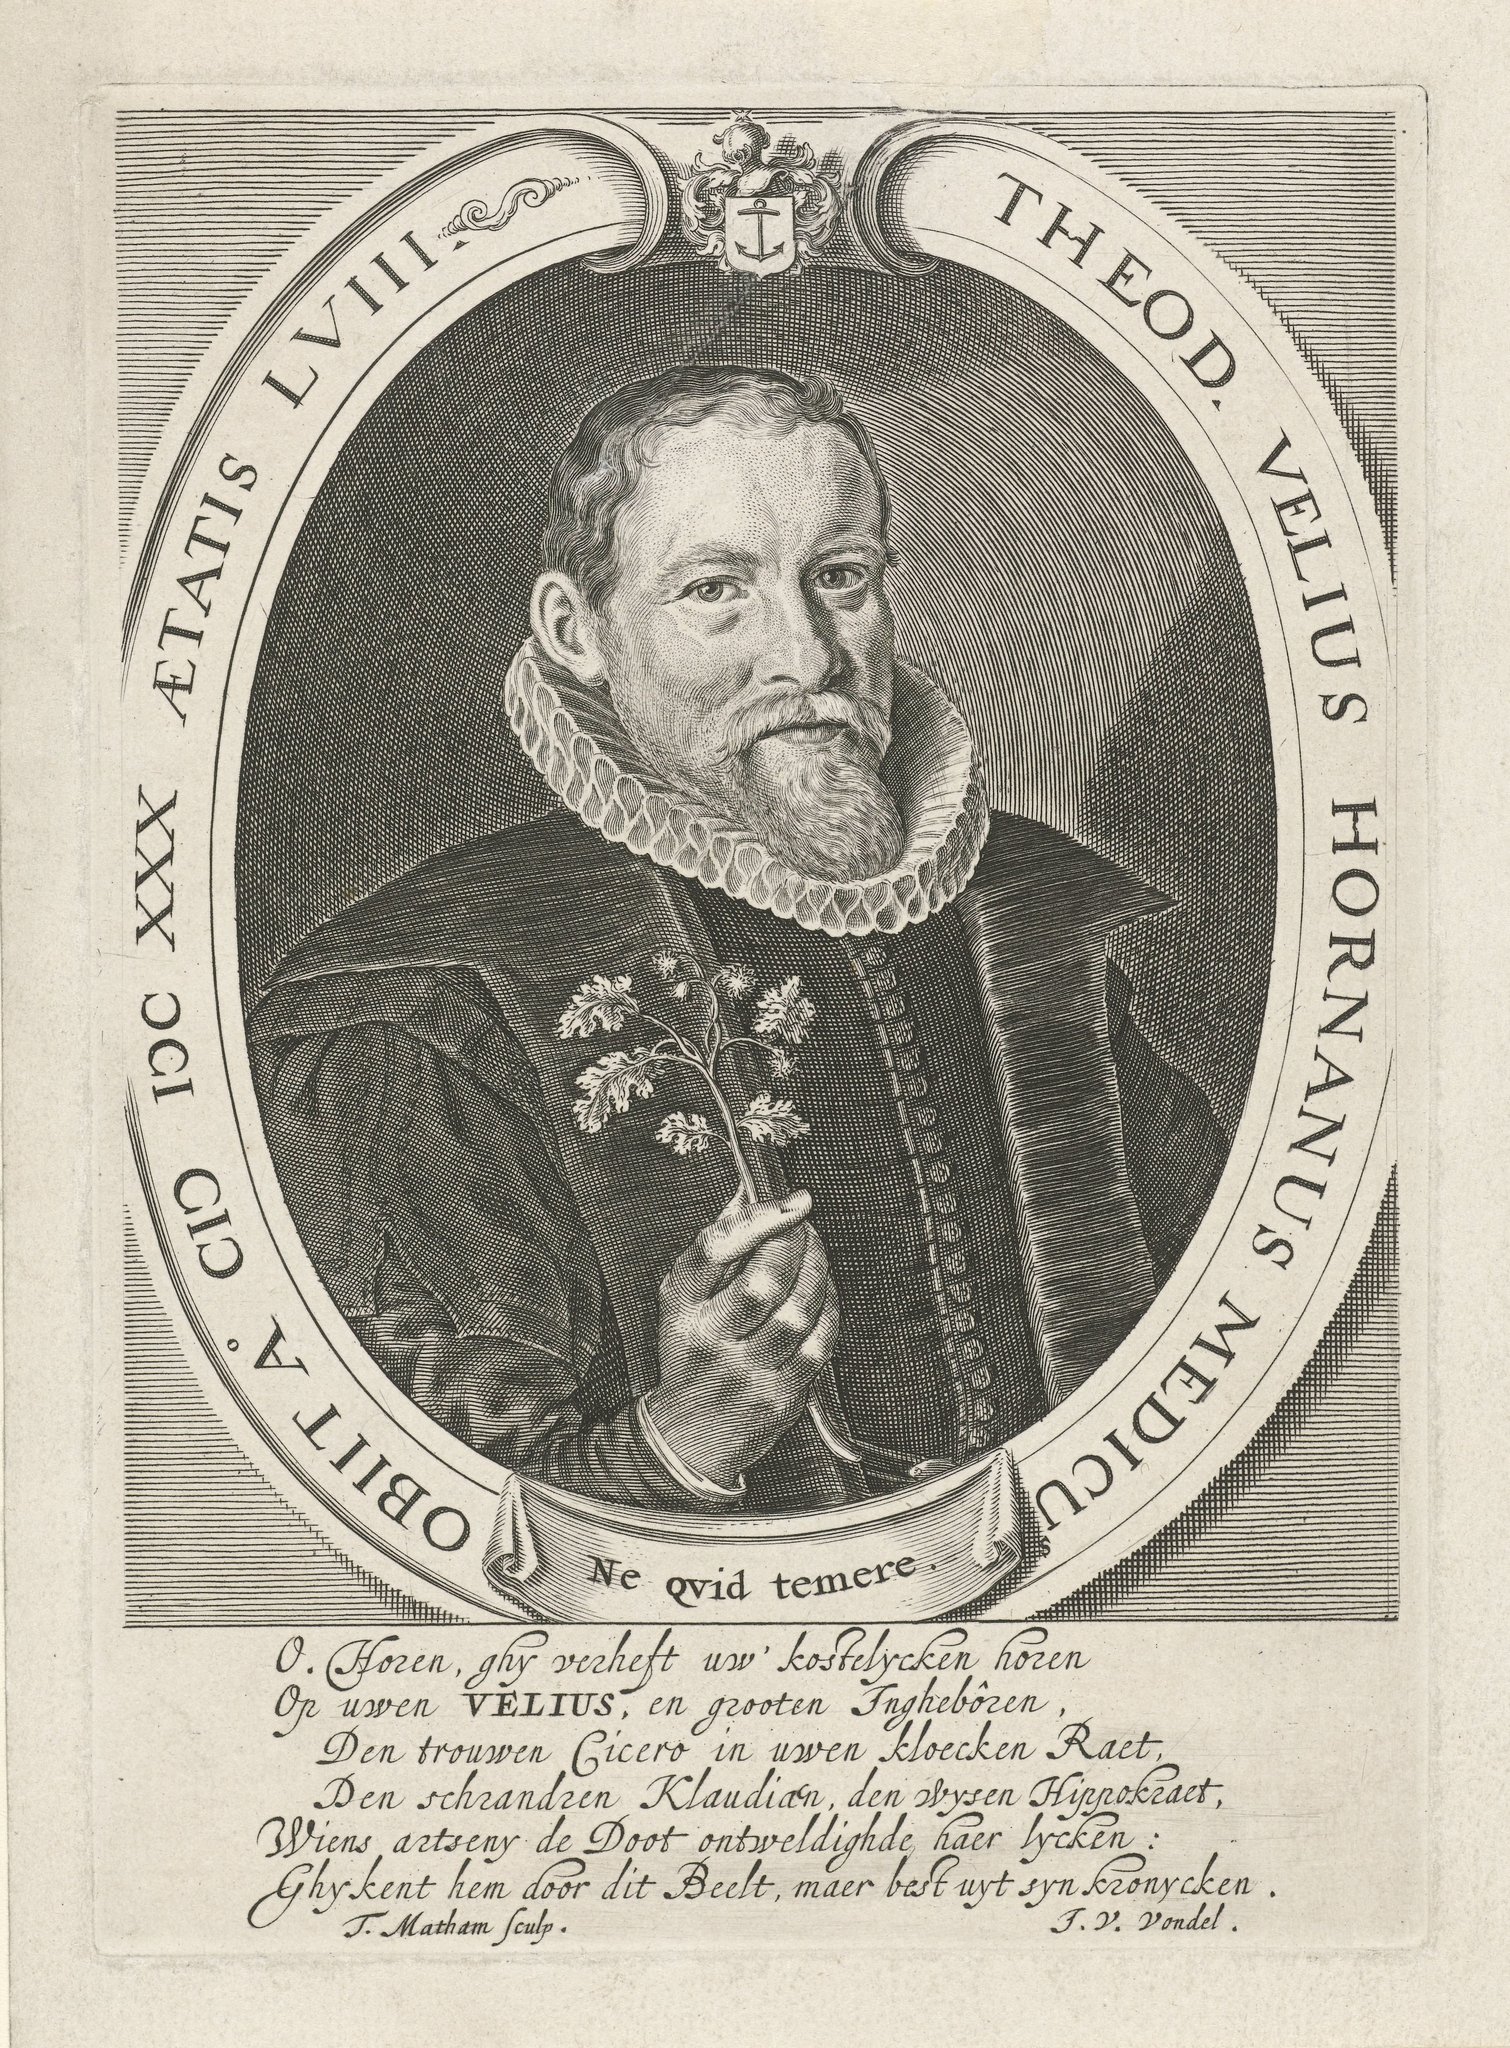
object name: print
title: Portret van Theodorus Velius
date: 1630-1676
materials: paper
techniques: engraving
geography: northern netherlands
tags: hoorn (north holland), theodorus velius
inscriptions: collector's mark: Lugt 2228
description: Portret van de Hoornse dichter en geschiedschrijver Theodorus Velius.